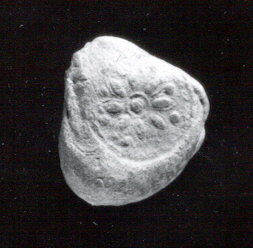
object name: sealing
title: Sealing impressed by stamp seal: geometric pattern, griffin-headed wheel; bearded male sphinx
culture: assyrian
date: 1800-1701 BCE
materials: clay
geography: anatolia